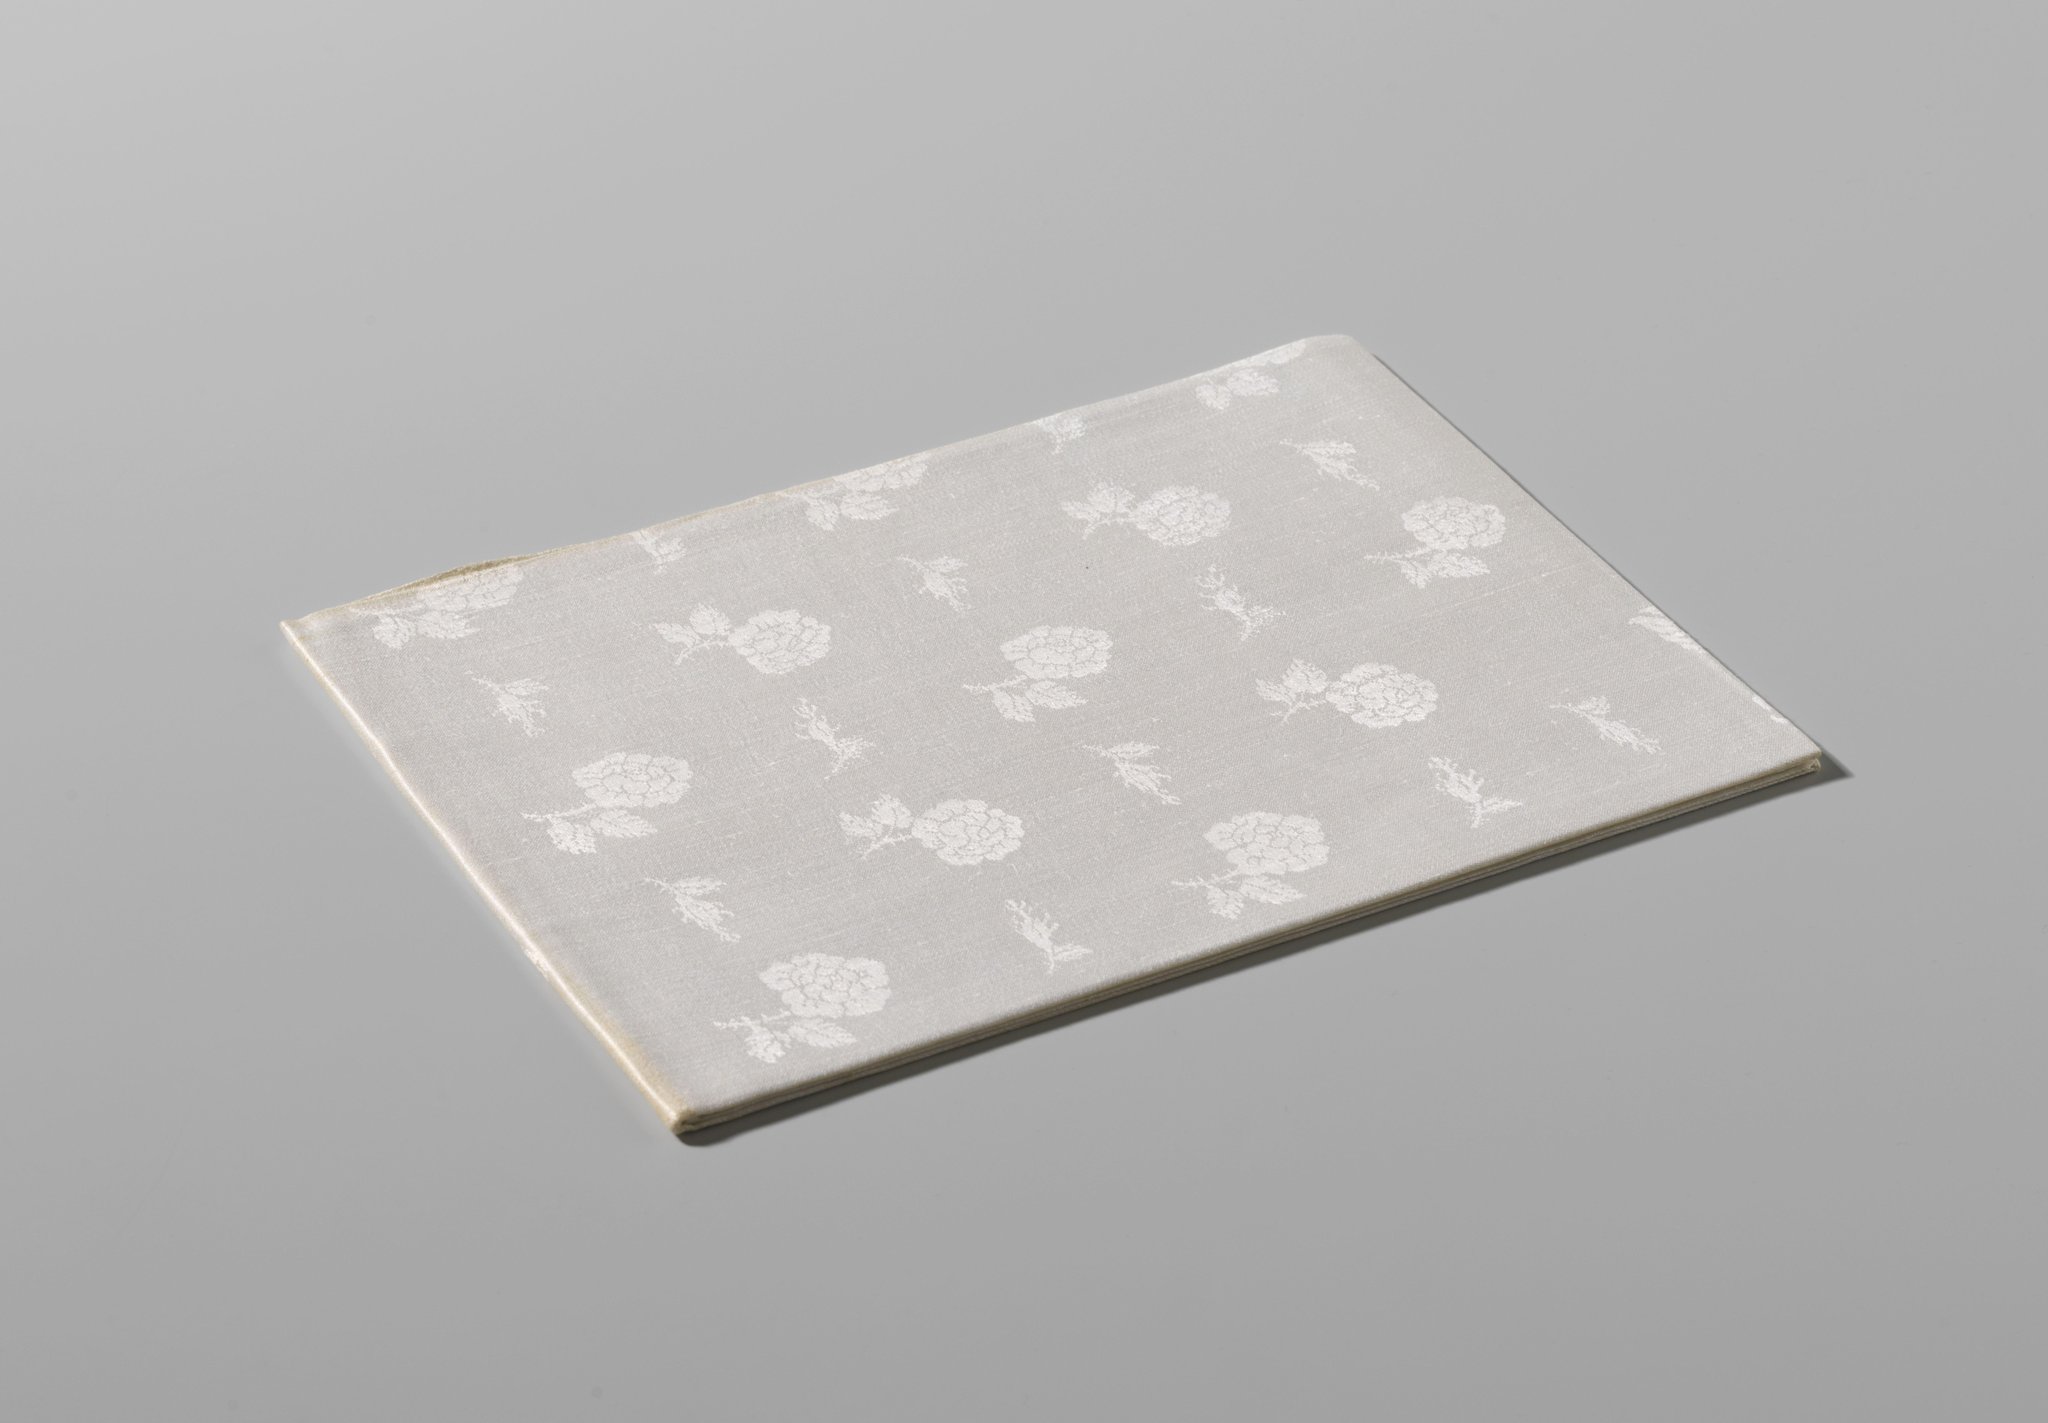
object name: napkin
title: Servet van wit linnendamast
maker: Anonymous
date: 1770-1795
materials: linen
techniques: damask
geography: northern netherlands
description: Wit linnen damasten servet met een patroon roosjes en rozenknoppen met een rand van rozetakken en een bloemboeket in de hoeken. Merk BSG en 42.